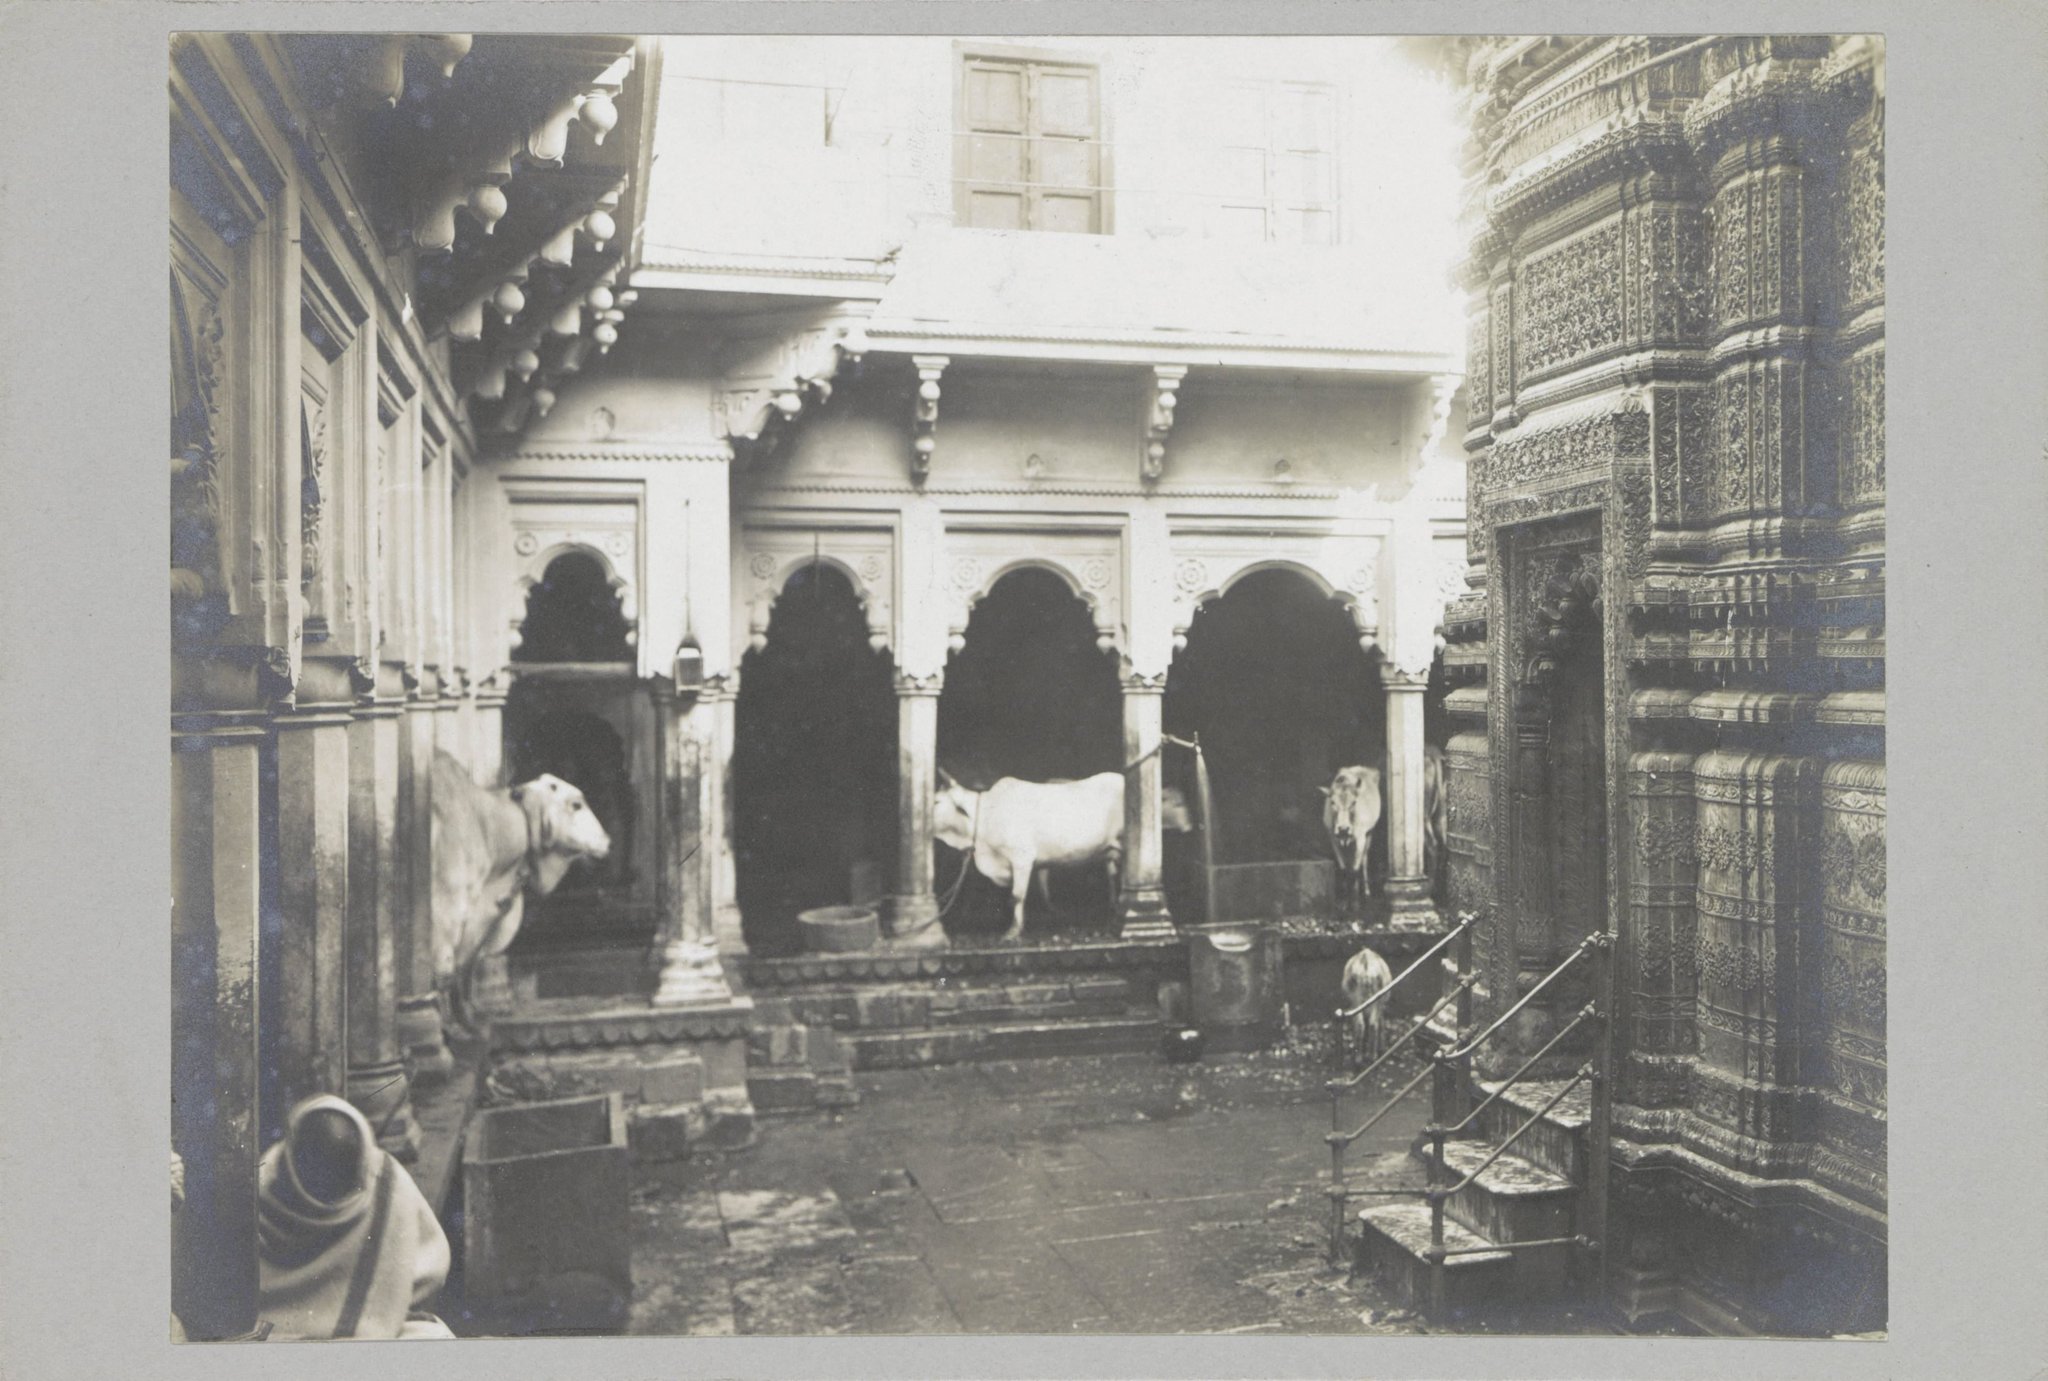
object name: photograph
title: Temple with holy cows in Varanasi, Uttar Pradesh, India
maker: Anonymous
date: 1895-1915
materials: cardboard, paper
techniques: gelatin silver print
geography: varanasi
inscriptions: annotation: ‘14a Tempel voor heilige koeien, Benares.’